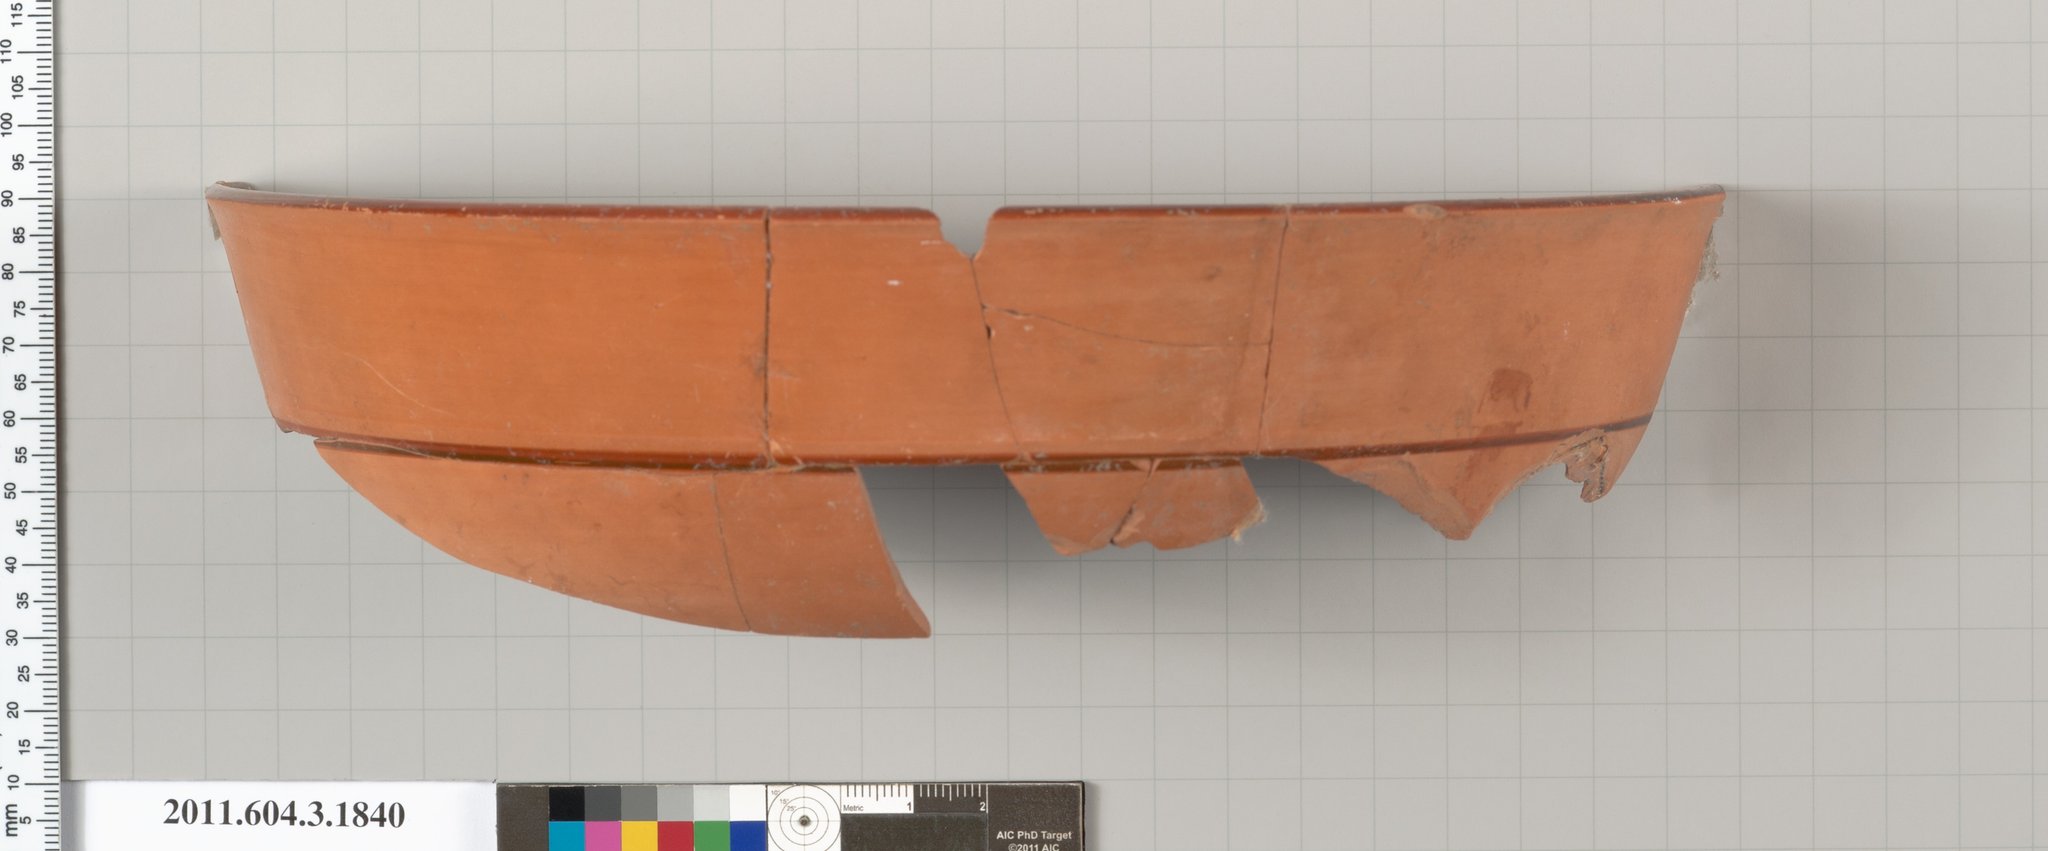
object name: kylix fragment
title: Terracotta fragment of a kylix: Band or lip cup (drinking cup)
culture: greek, attic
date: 560-525 BCE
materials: terracotta